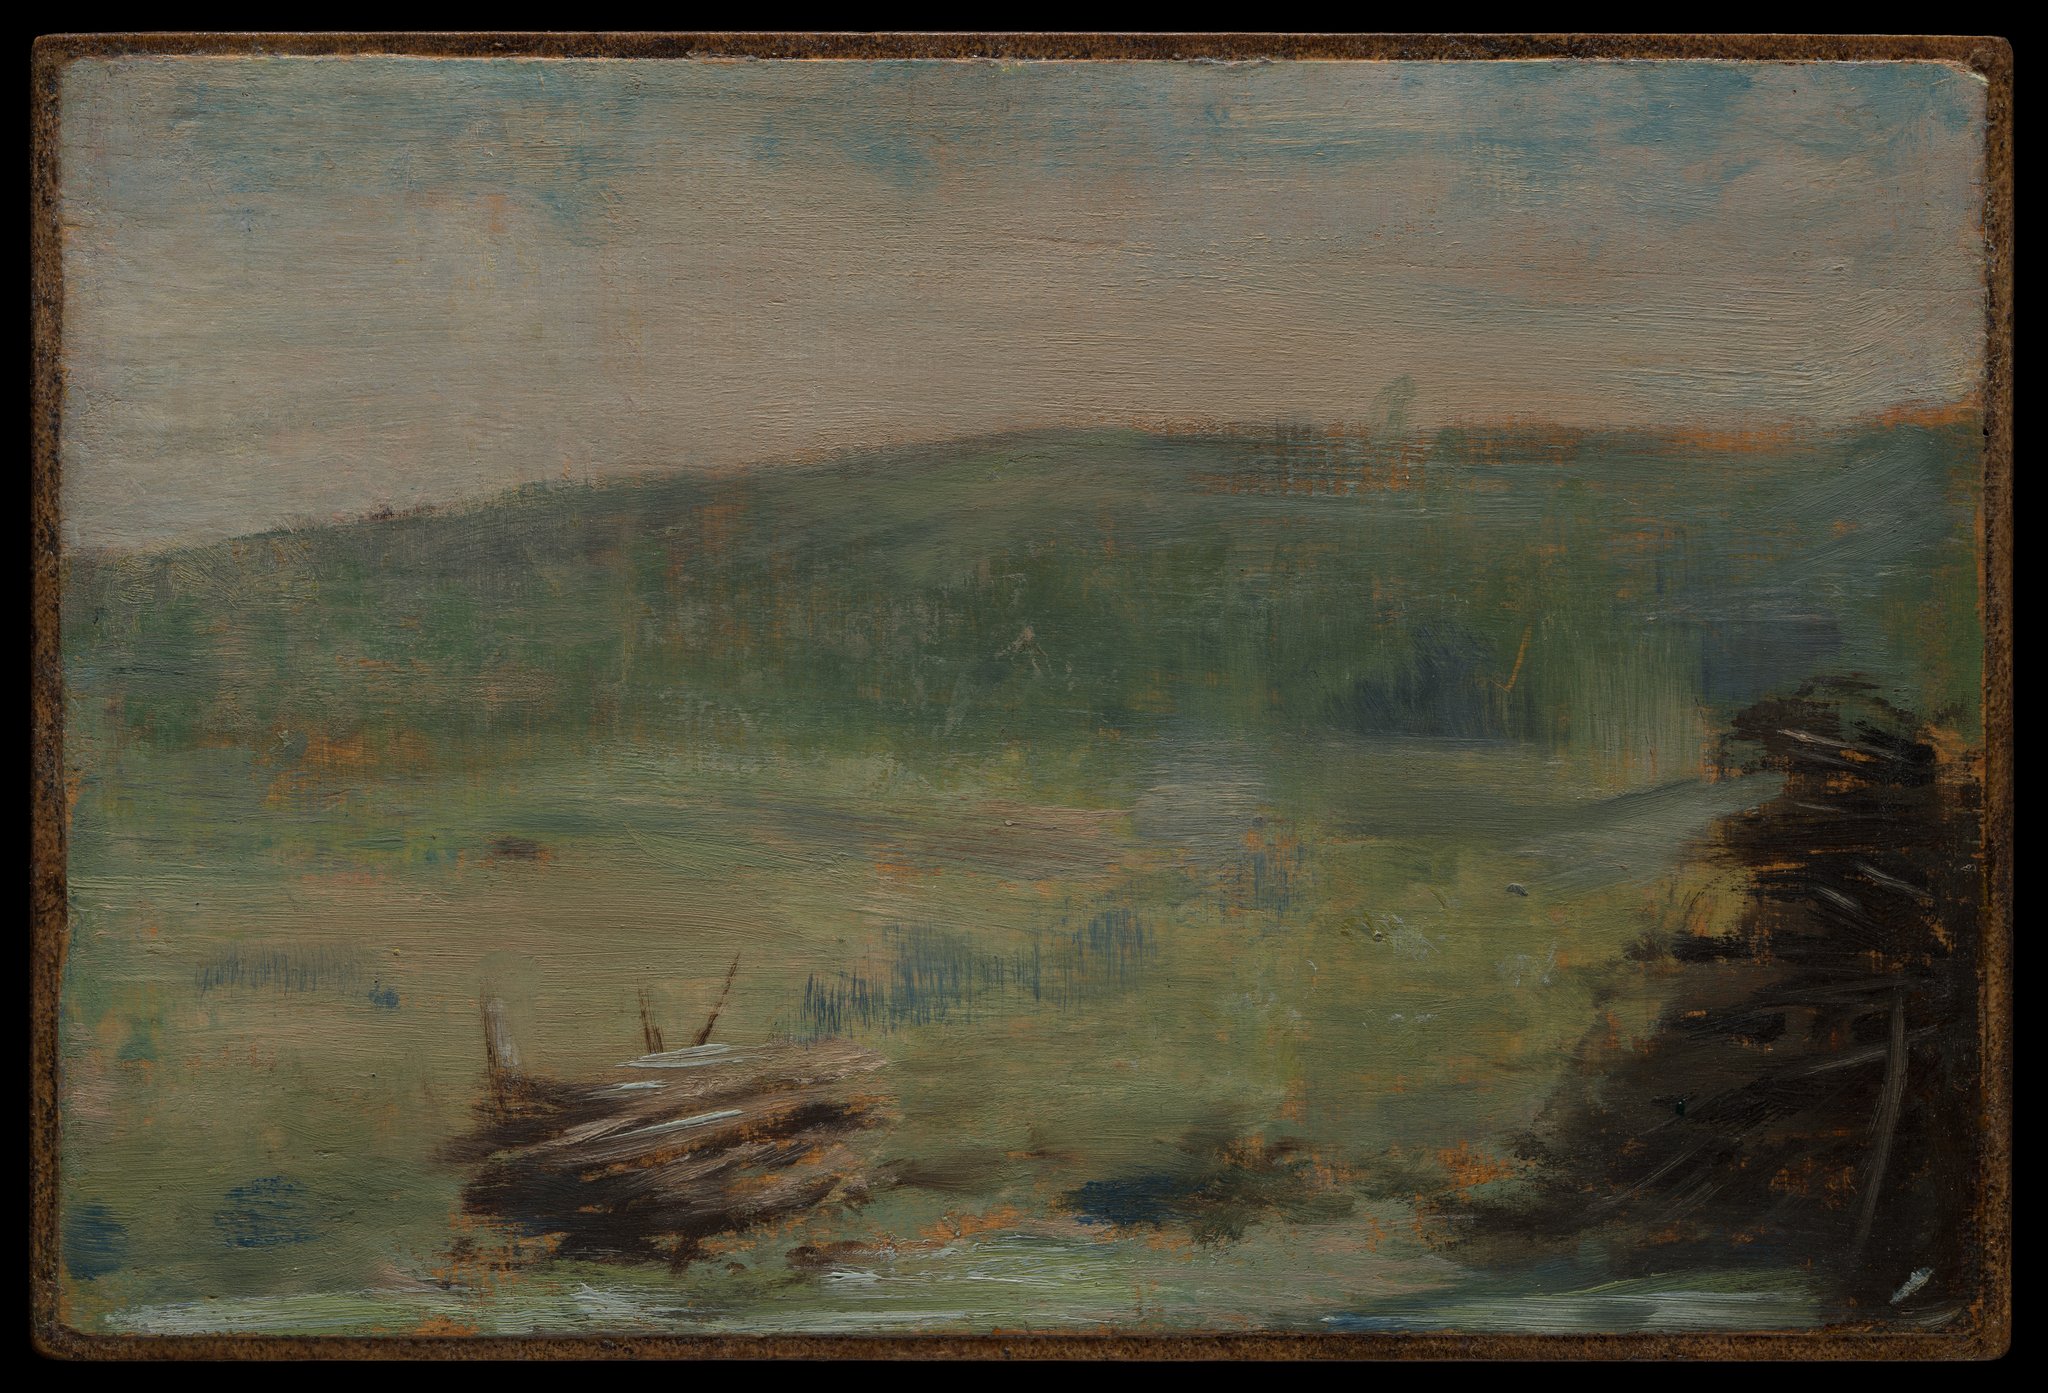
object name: painting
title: Landscape at Saint-Ouen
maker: georges seurat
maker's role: artist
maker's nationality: french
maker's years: 1859-1891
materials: oil, wood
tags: landscapes